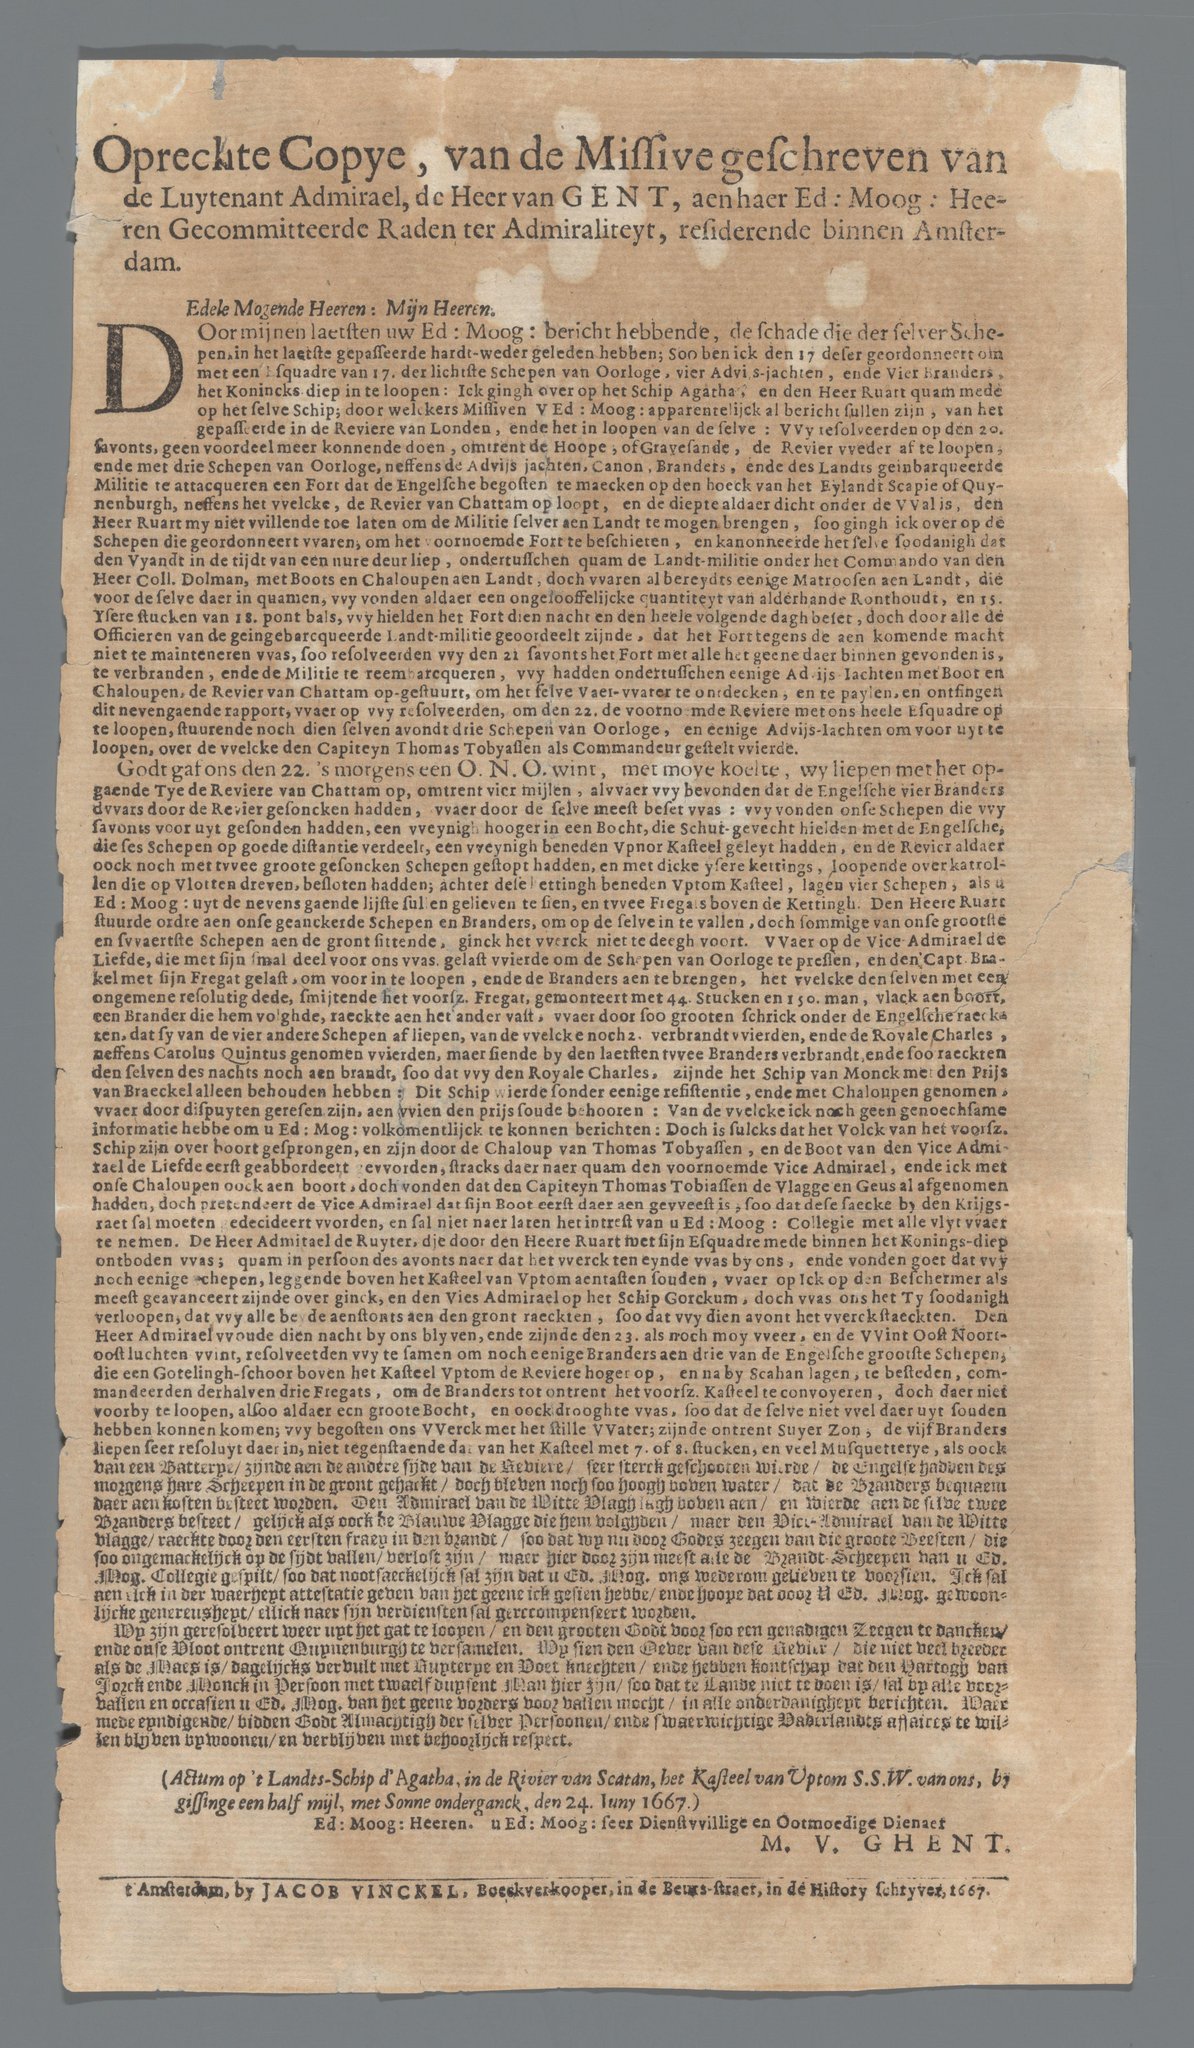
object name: pamphlet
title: Oprechte Copye, van de Missive geschreven van de Luytenant Admirael, de Heer Van Gent...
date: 1667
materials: paper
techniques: printing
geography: amsterdam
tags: amsterdam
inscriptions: date